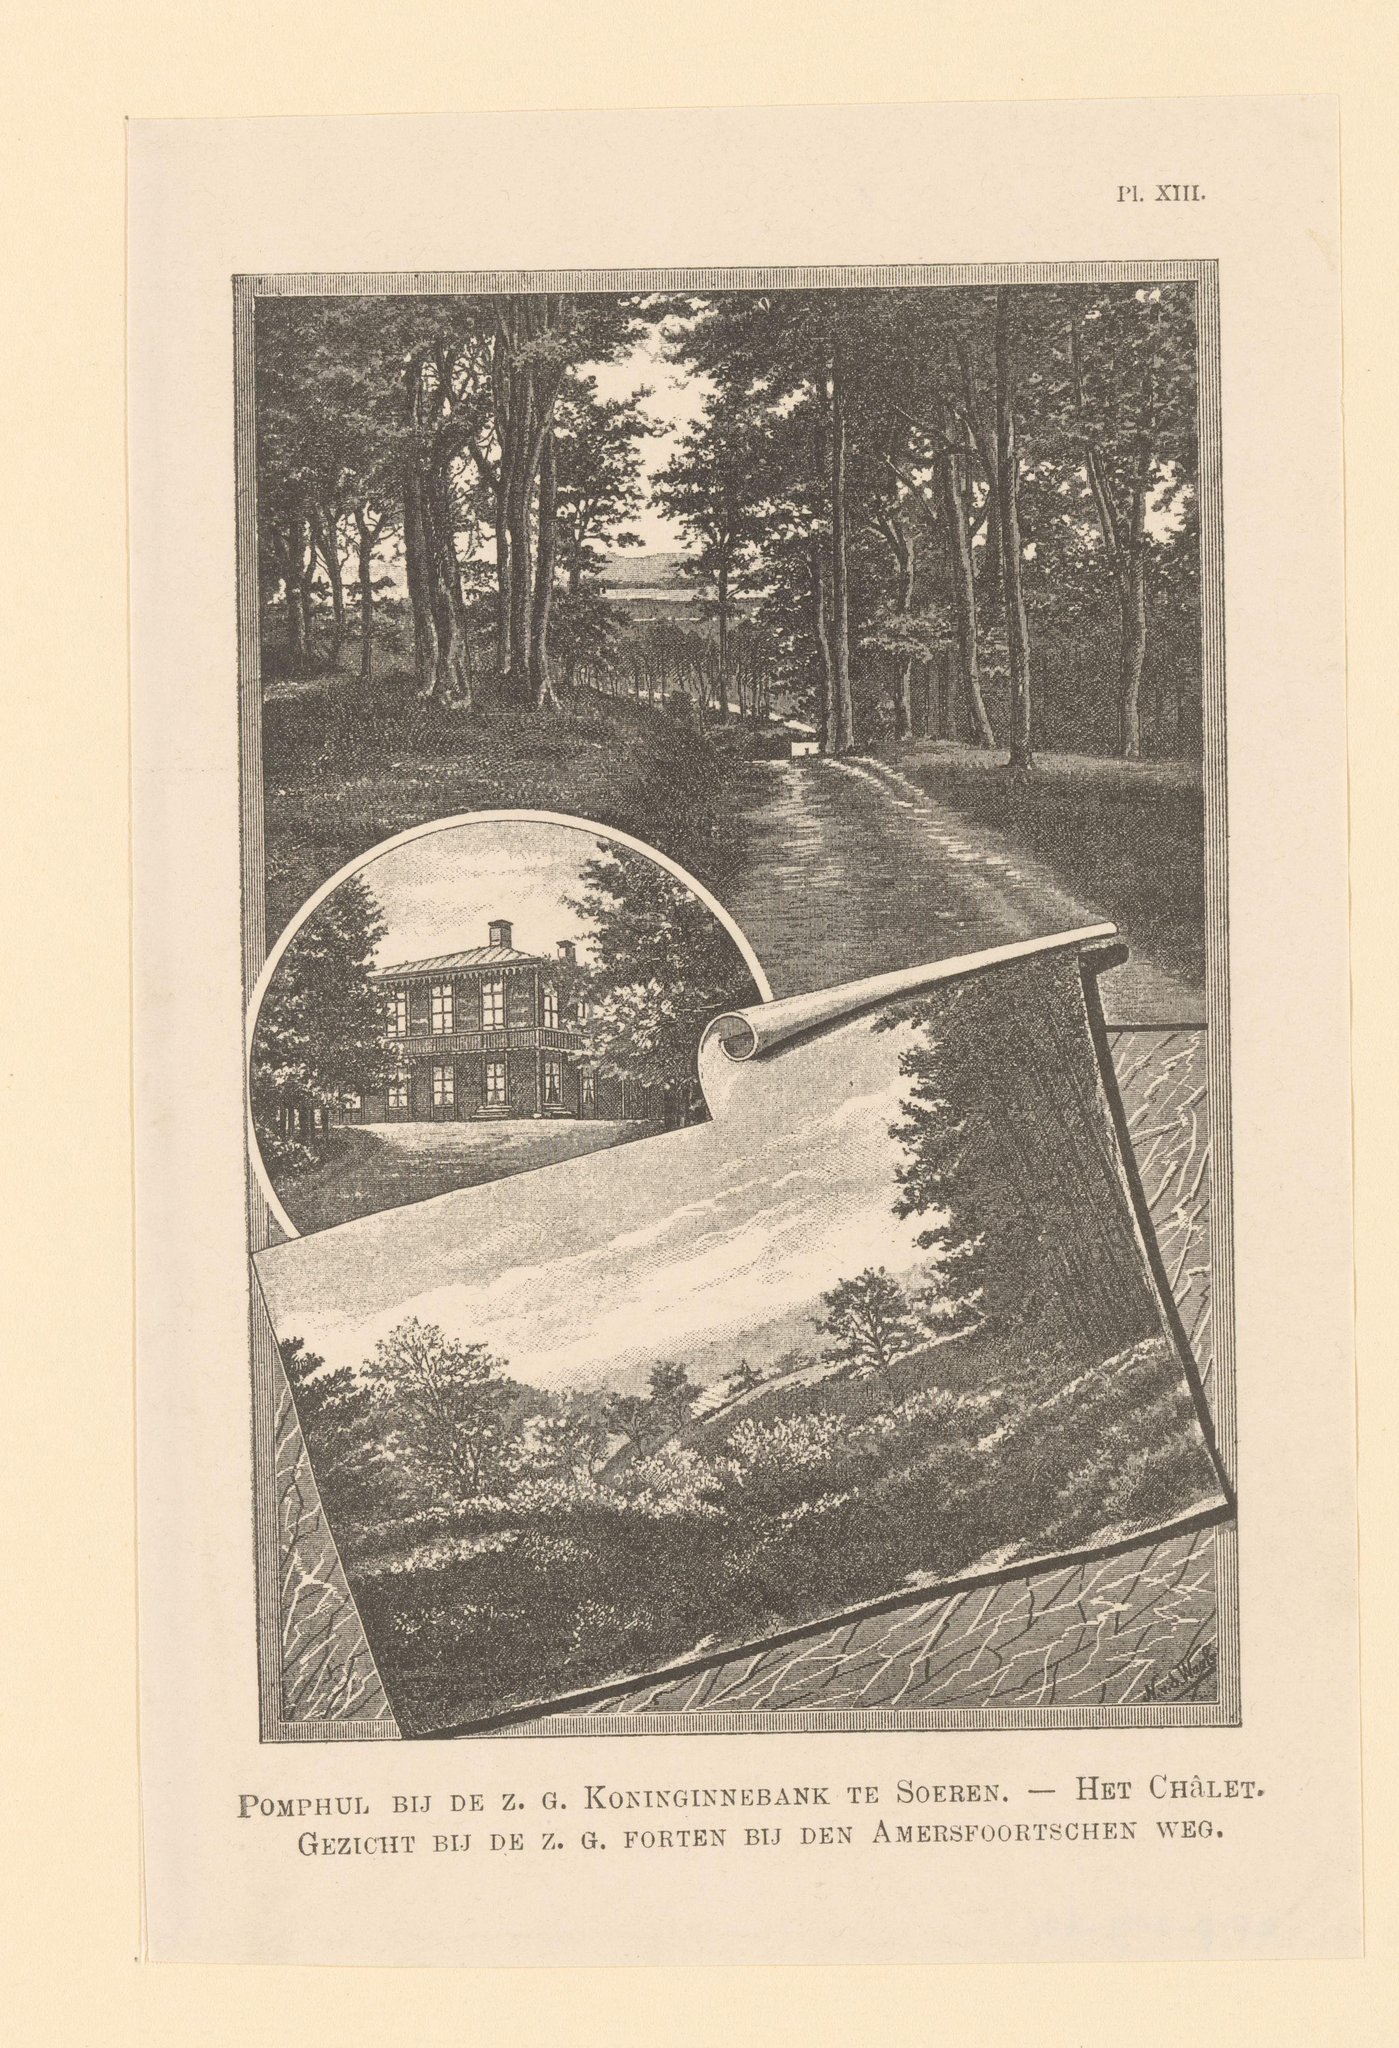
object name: photomechanical print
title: Pomphul bij de Z.G. Koninginnebank te Soeren. - Het Châlet. Gezicht bij de Z.G. Forten bij den Amersfoortschen weg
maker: noach van der waals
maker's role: print maker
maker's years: 1852-1930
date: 1890-1900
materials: paper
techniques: autotype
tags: city-view, and landscape with man-made constructions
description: Prent mogelijk uit: Gids voor Apeldoorn en omstreken. Apeldoorn: Vereeniging tot veraangenaming van het verblijf te Apeldoorn, [1891-1897].